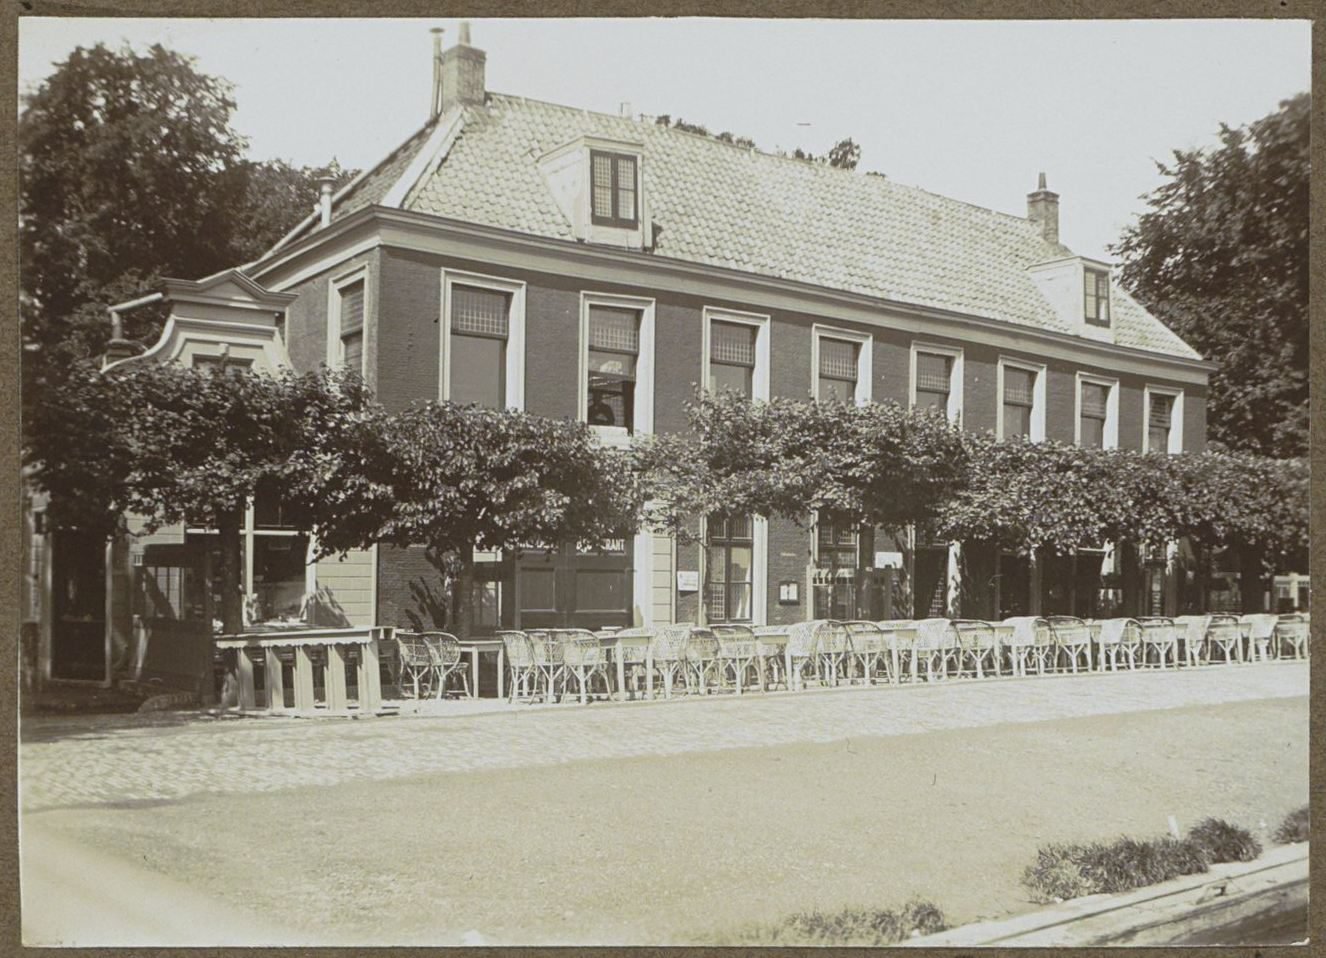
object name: photograph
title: Café Het Oude Kalfje aan de Amsteldijk te Amsterdam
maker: Anonymous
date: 1910-1930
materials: paper, photographic support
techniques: gelatin silver print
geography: amsterdam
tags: hotel, hostelry, inn, amsterdam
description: Onderdeel van Album met foto's van Amsterdam en omgeving.